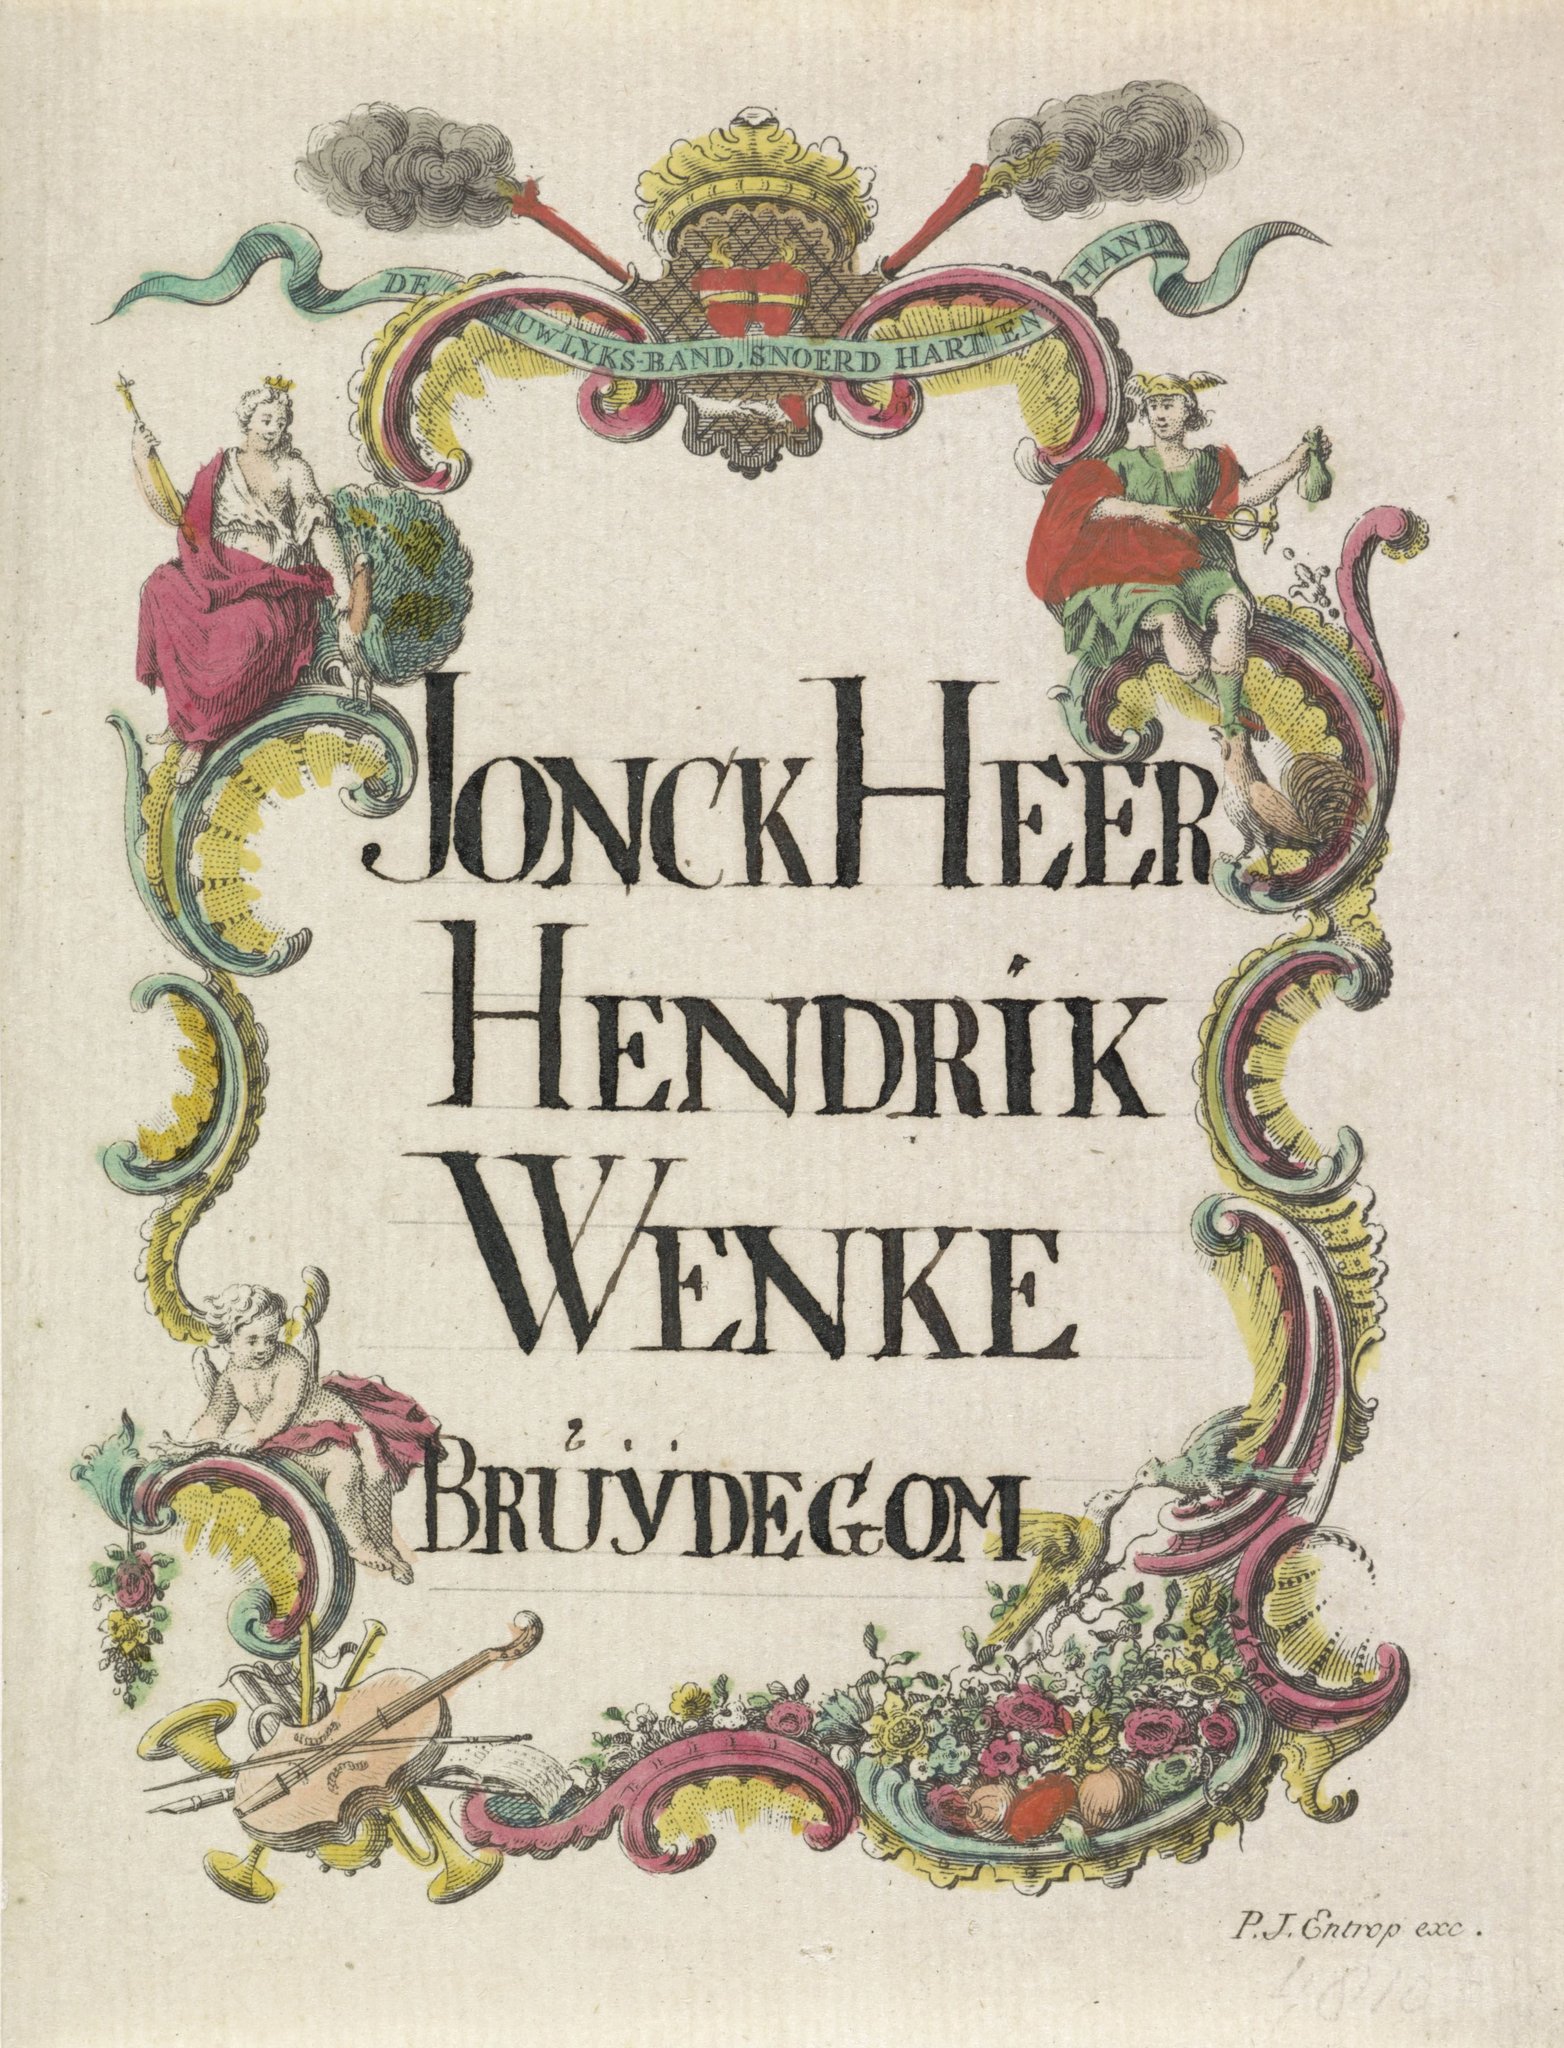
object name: print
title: Naamkaart voor de bruidegom, ca. 1760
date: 1755-1775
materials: paper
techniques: engraving, etching, hand coloring, writing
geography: amsterdam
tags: amsterdam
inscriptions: collector's mark: Lugt 2228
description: Versierde naamkaartje voor de bruidegom Hendrik Wenke, ca. 1760. Voorgedrukte omlijsting met rocailles en figuren. Zie ook pendant.